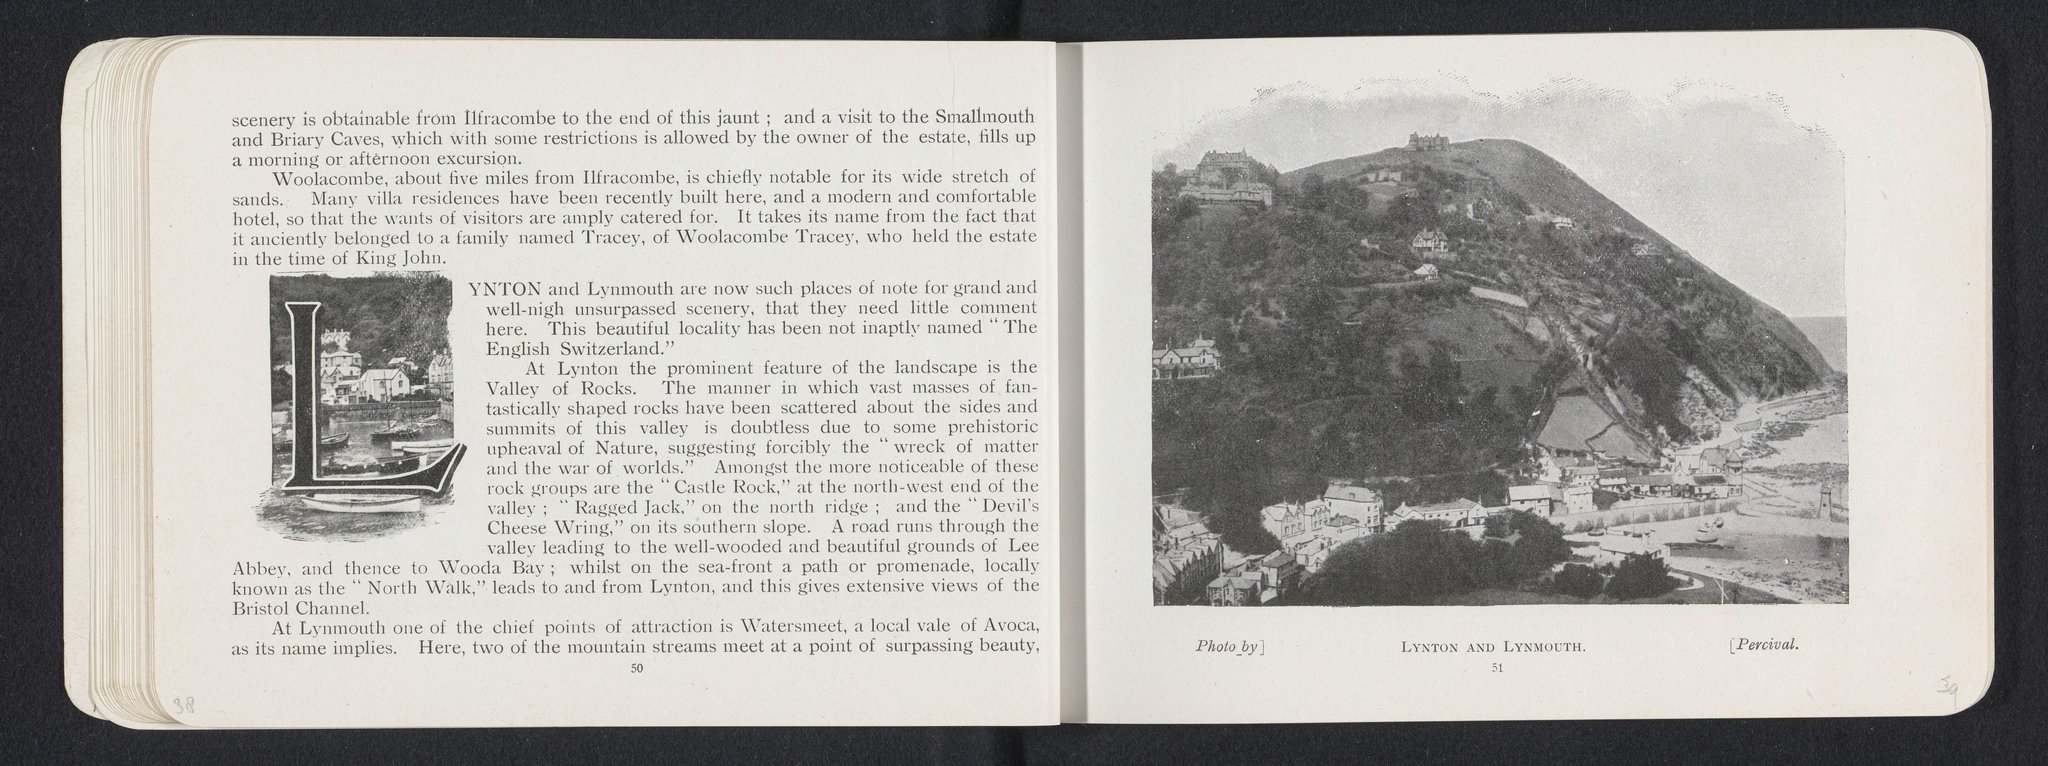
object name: page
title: Gezicht op Lynmouth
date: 1900-1920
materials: paper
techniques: autotype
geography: devon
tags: harbour, city-view in general; 'veduta'